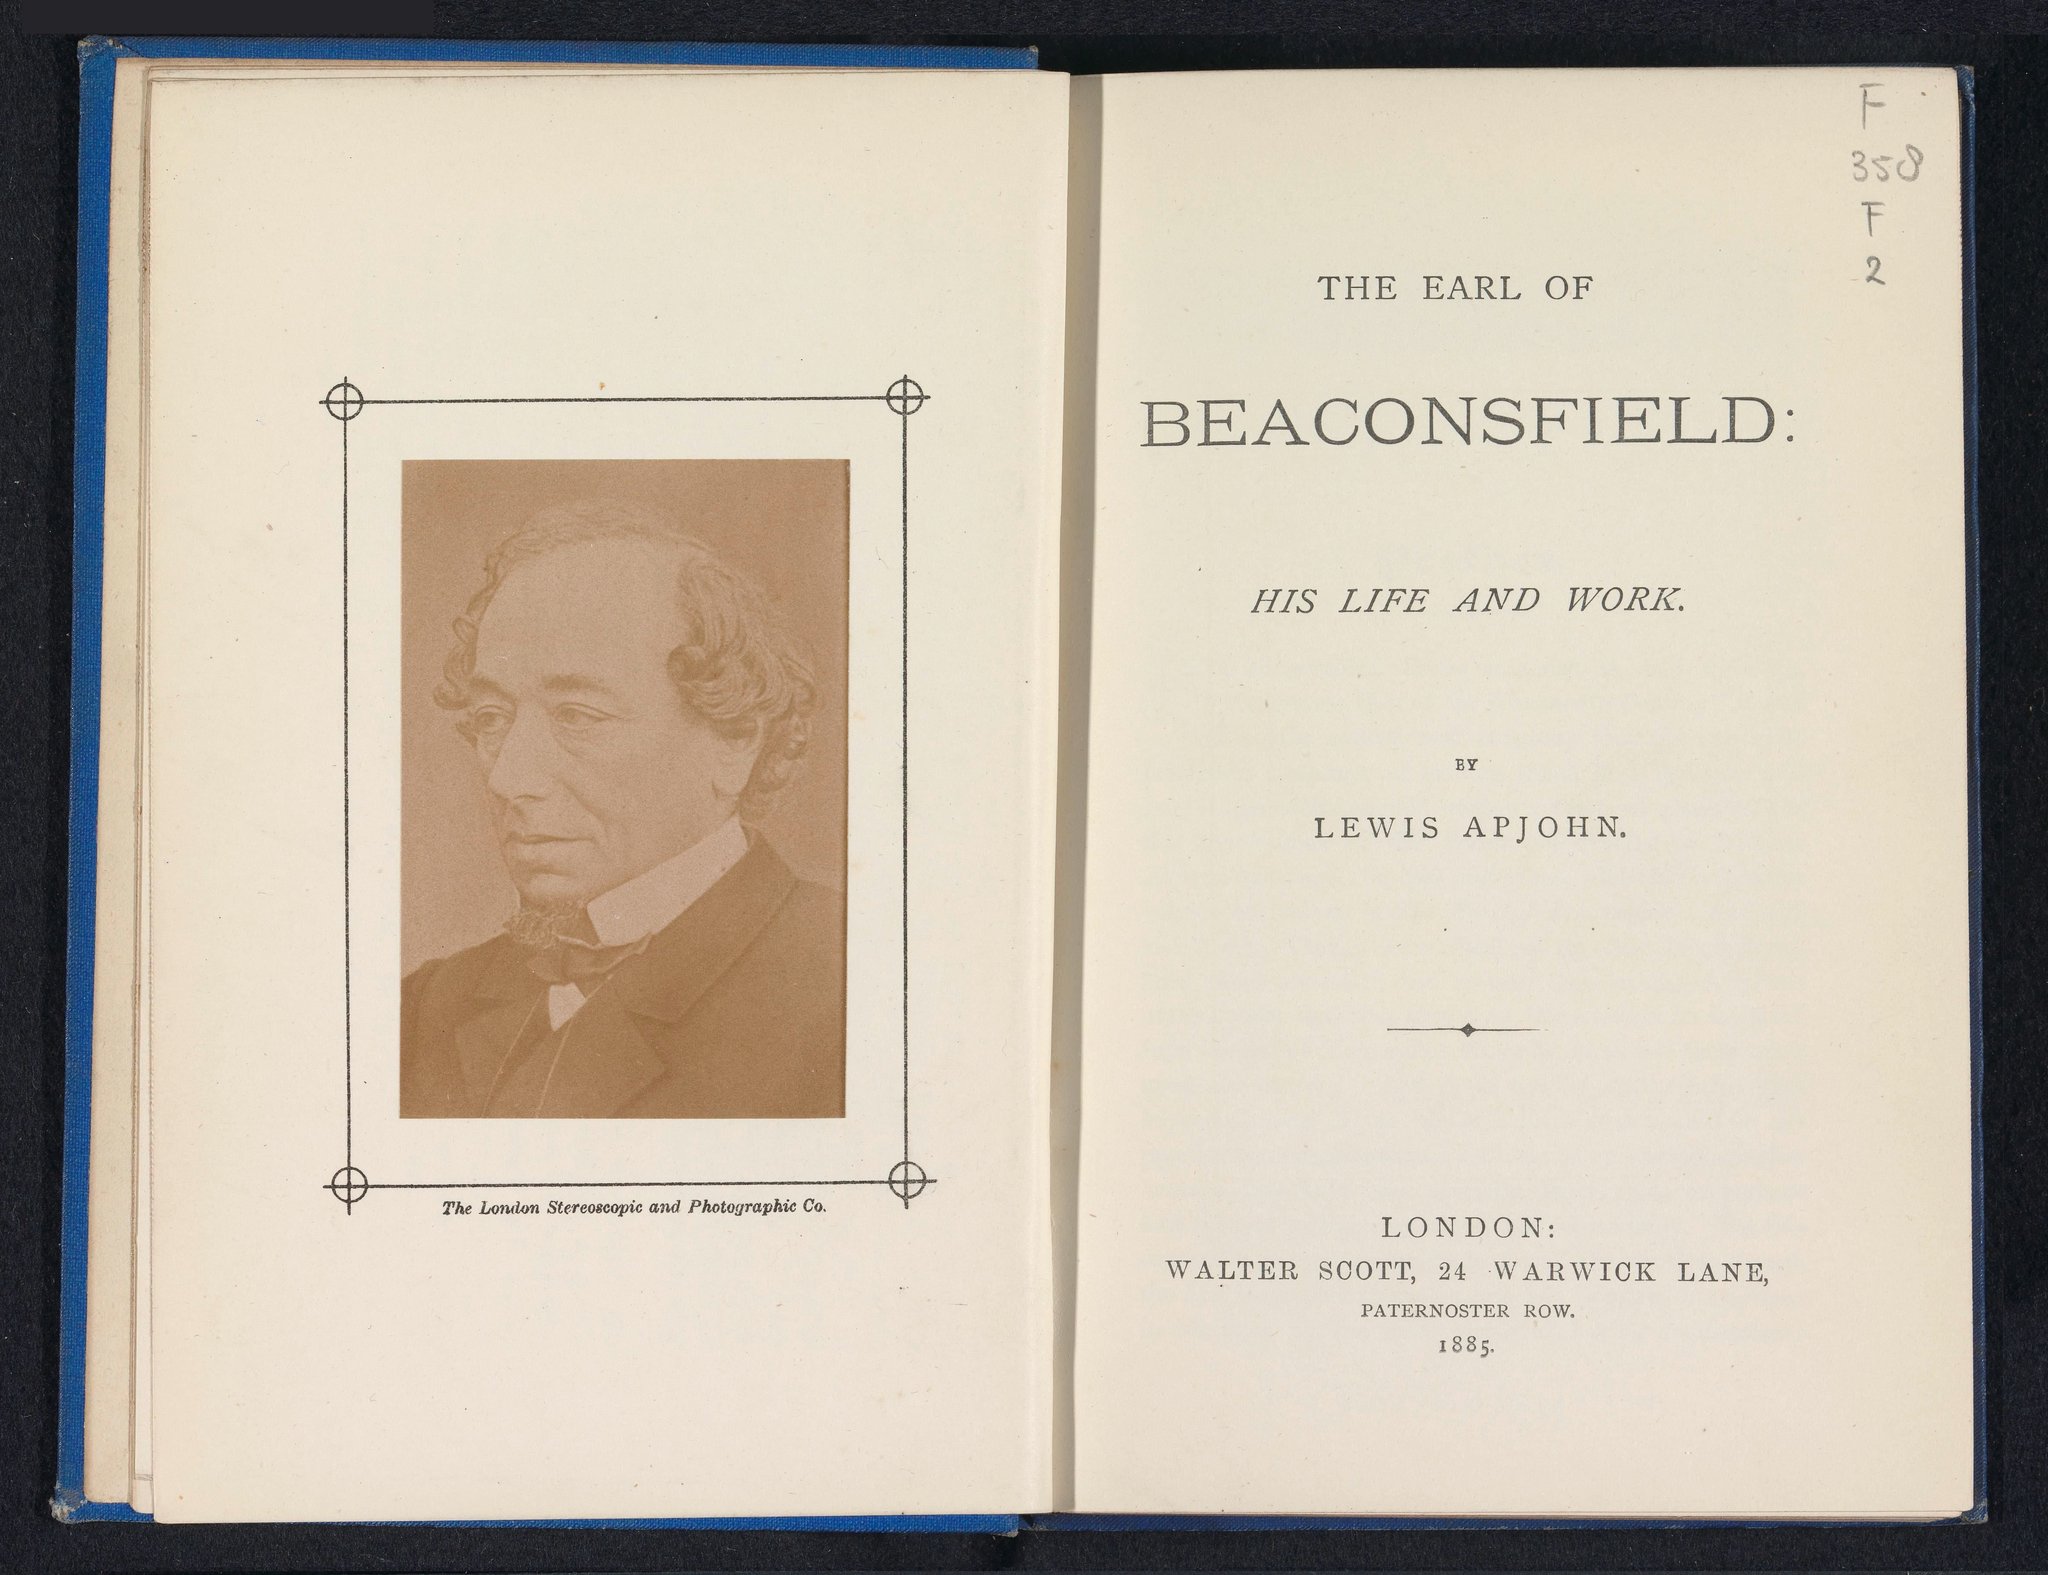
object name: photograph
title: Portret van Benjamin Disraeli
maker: Anonymous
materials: photographic support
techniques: albumen print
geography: london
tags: politician, adult man